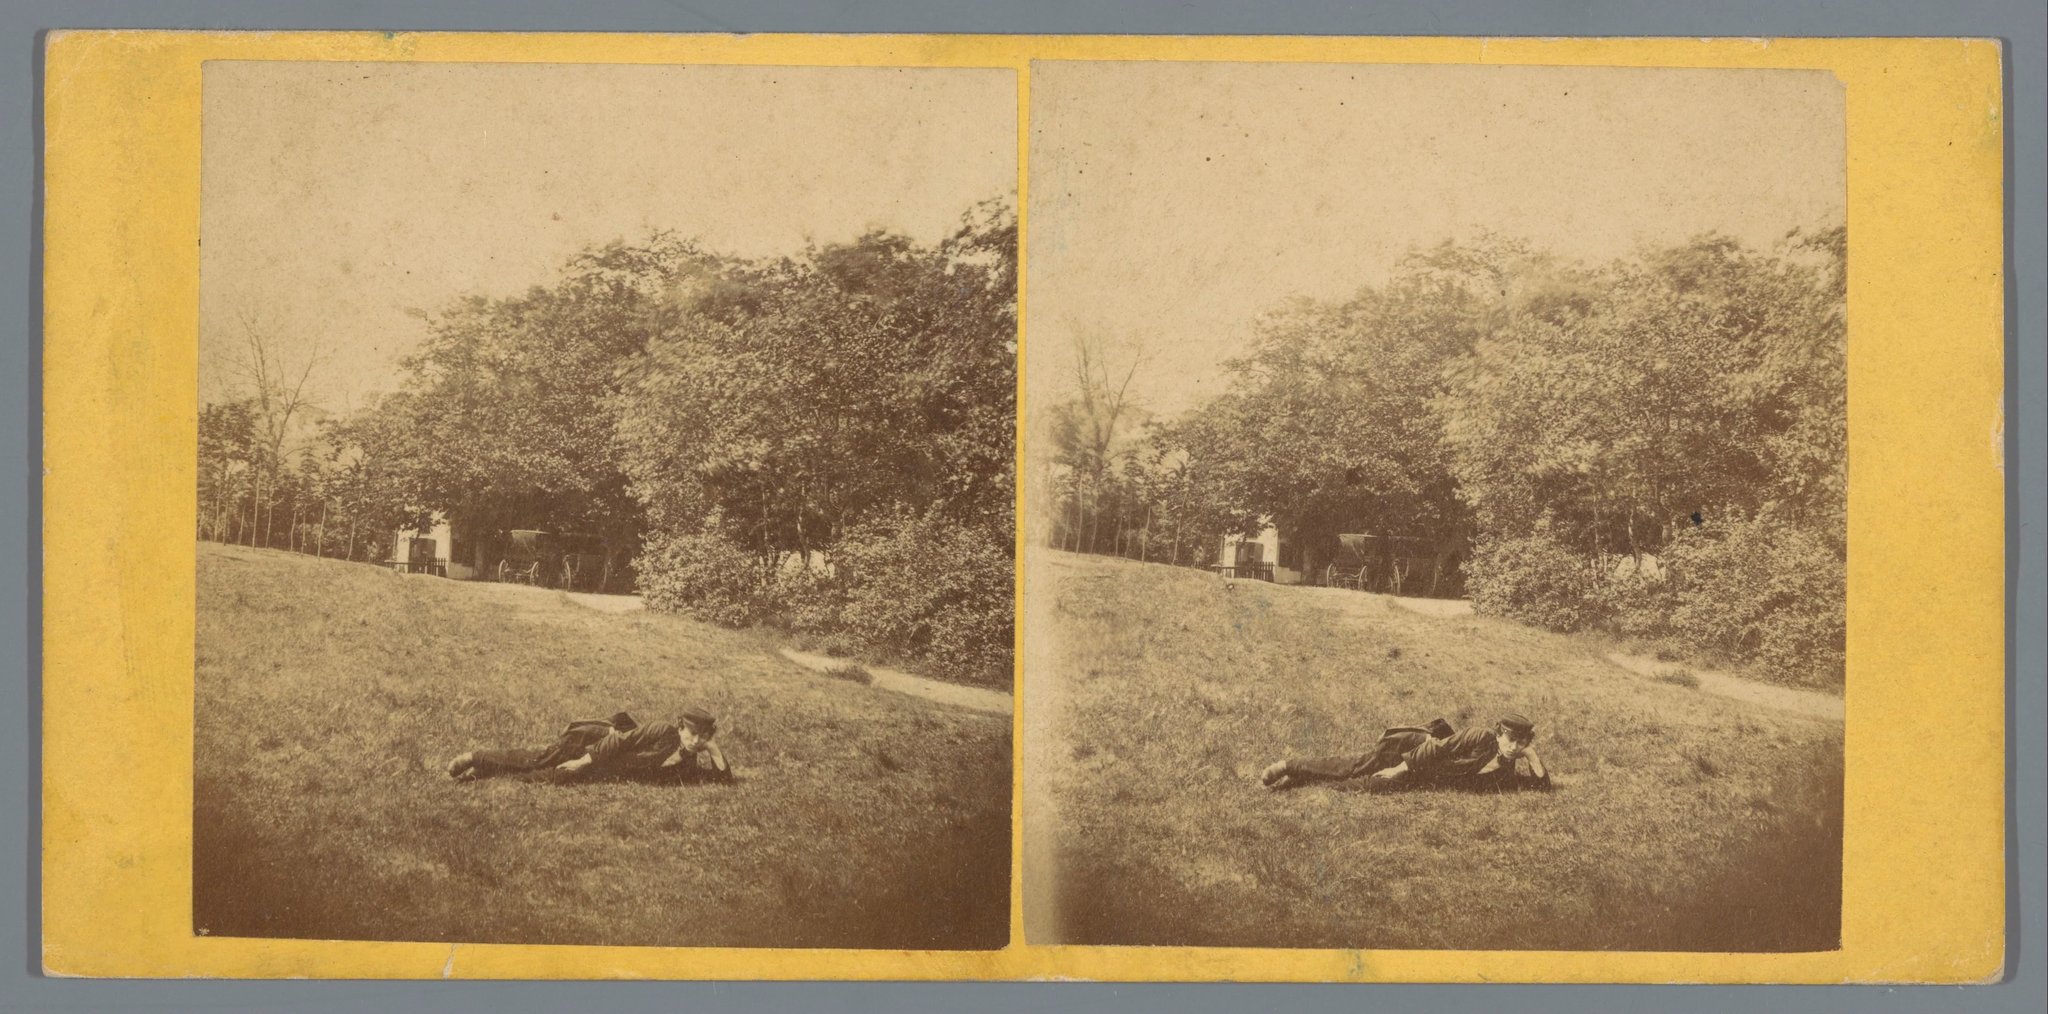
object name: stereograph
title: Man liggend in het gras met op de achtergrond een huisje met koetsen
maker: Anonymous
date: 1850-1880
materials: cardboard, photographic support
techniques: albumen print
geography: europe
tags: bus, coach, lawn, europe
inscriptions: number: ‘224’